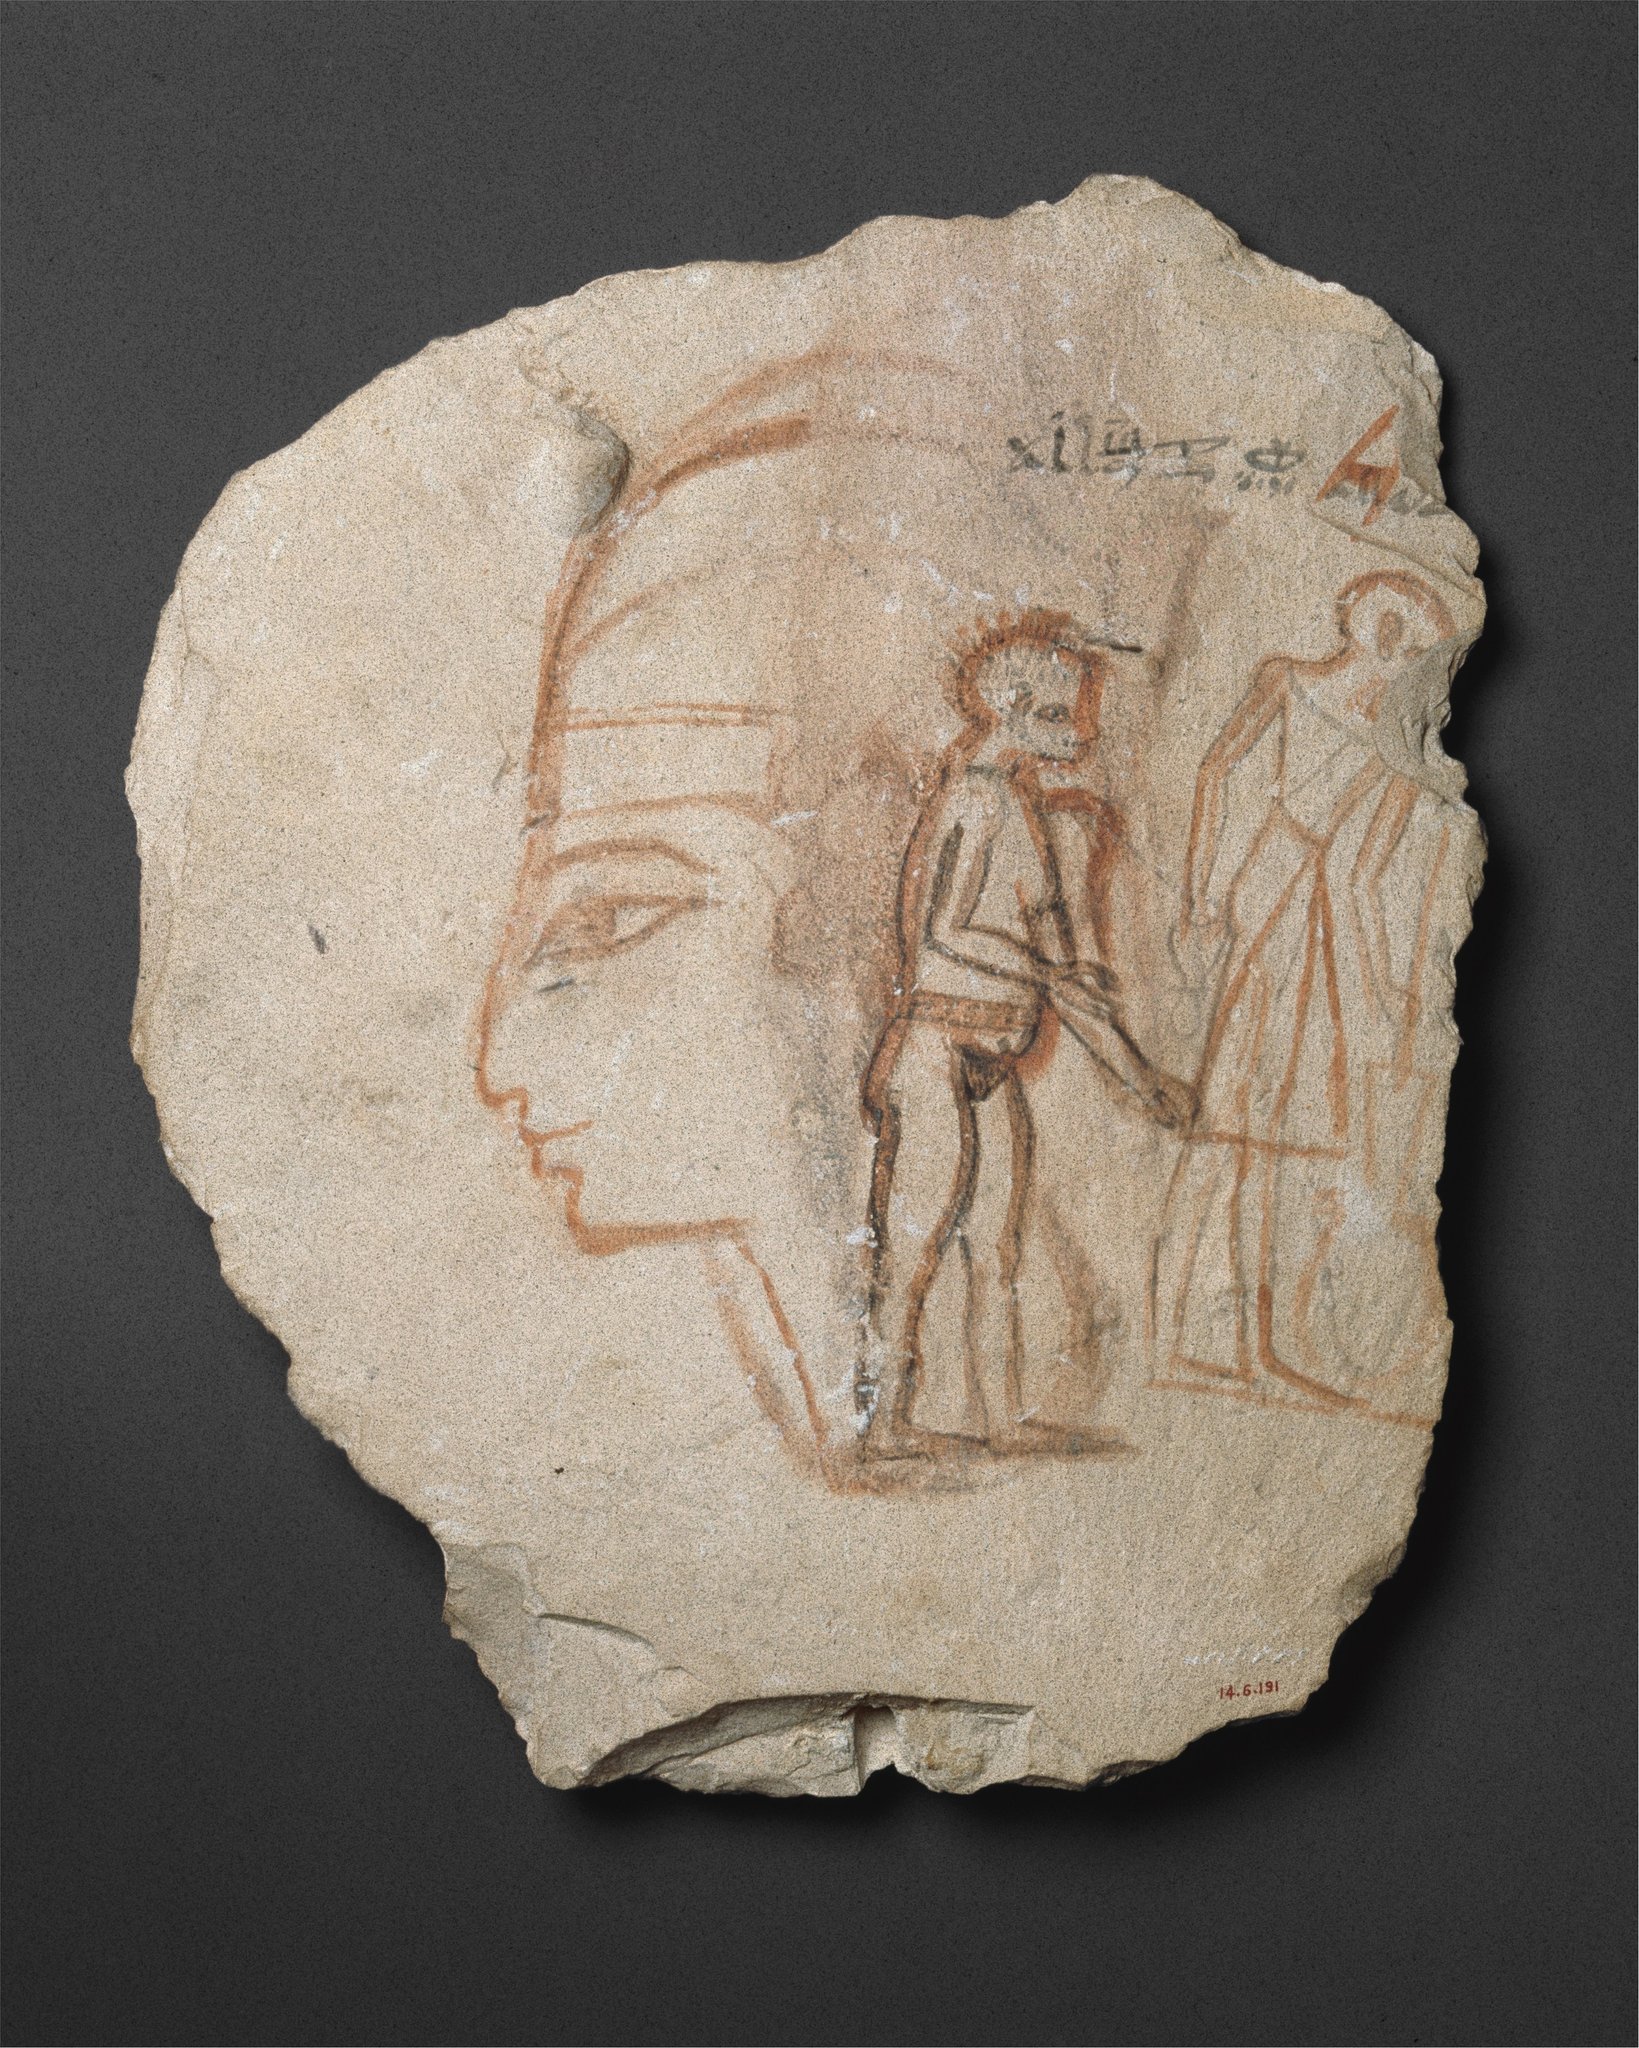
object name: ostracon, figured, king, nude woman, man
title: Drawing of a Ramesside King and Two Standing Figures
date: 1295-1070 BCE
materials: ink, limestone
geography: egypt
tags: kings